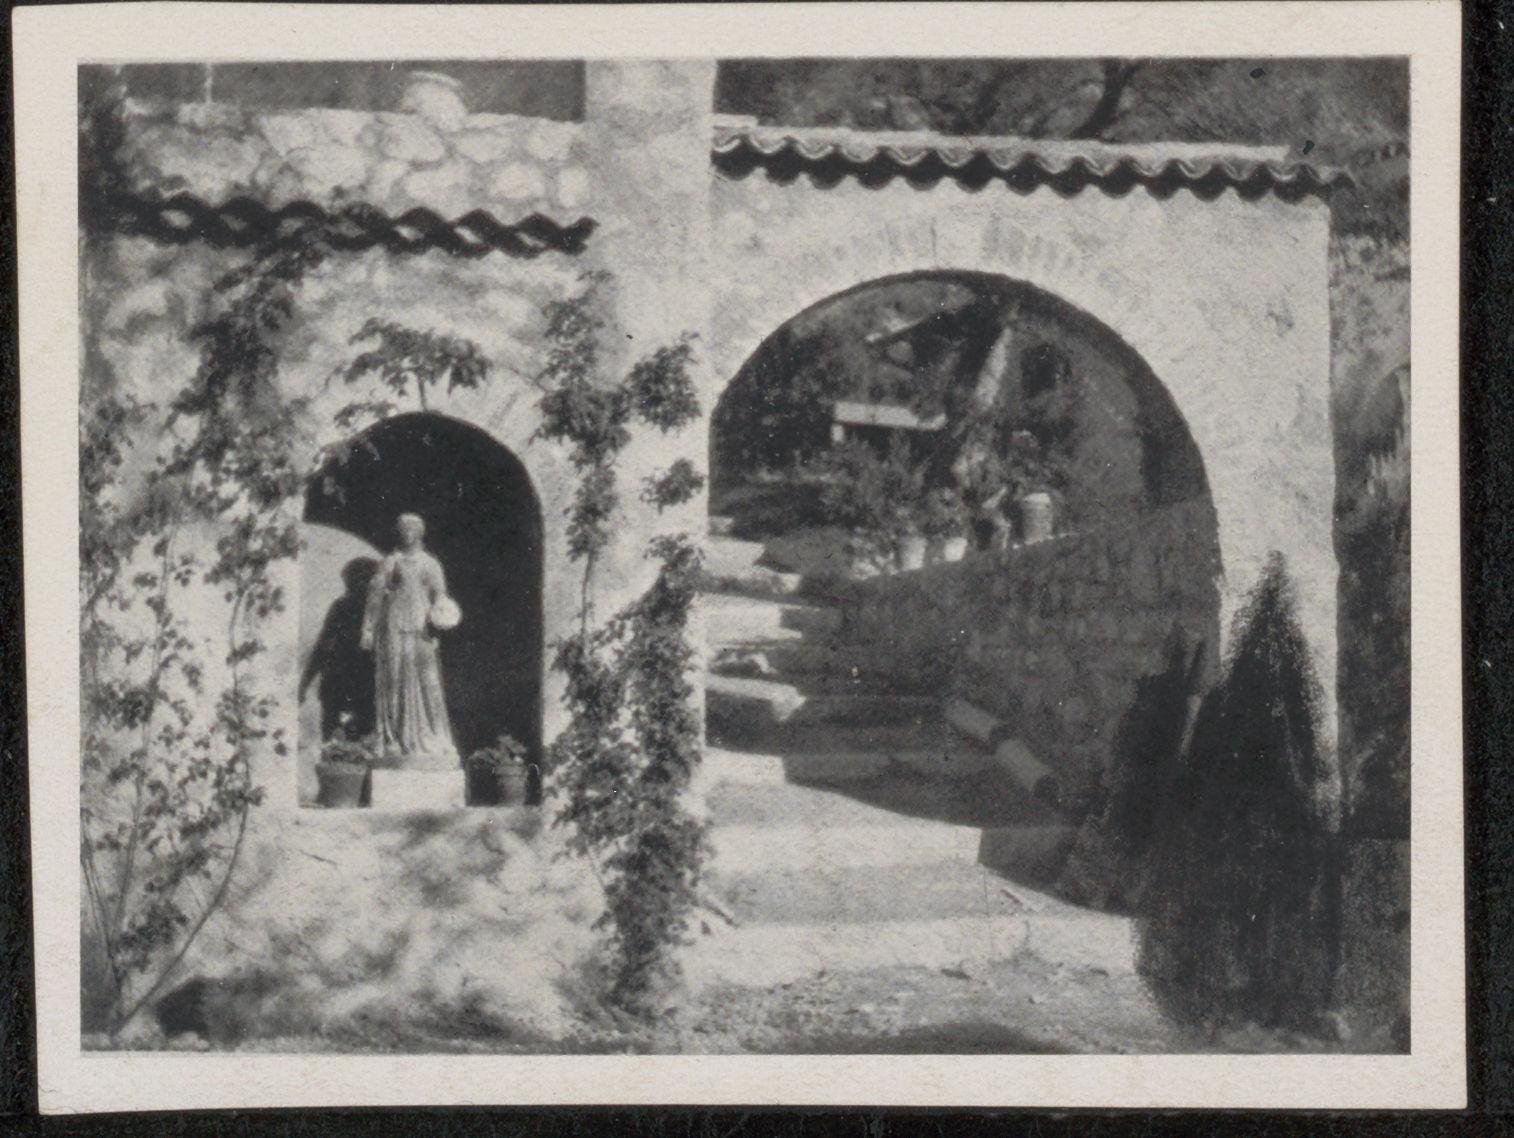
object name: ansichtkaart, prentbriefkaart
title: Prentbriefkaart aan Philip Zilcken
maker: ferdinand-sigismund bac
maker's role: draughtsman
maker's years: 1859-1952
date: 1869-1952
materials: cardboard, ink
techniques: pen, printing, writing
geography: compiègne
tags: the hague, painter, draughtsman, philip zilcken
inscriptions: collector's mark: ‘RPK’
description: Bevat drie onbeschreven prentbriefkaarten.